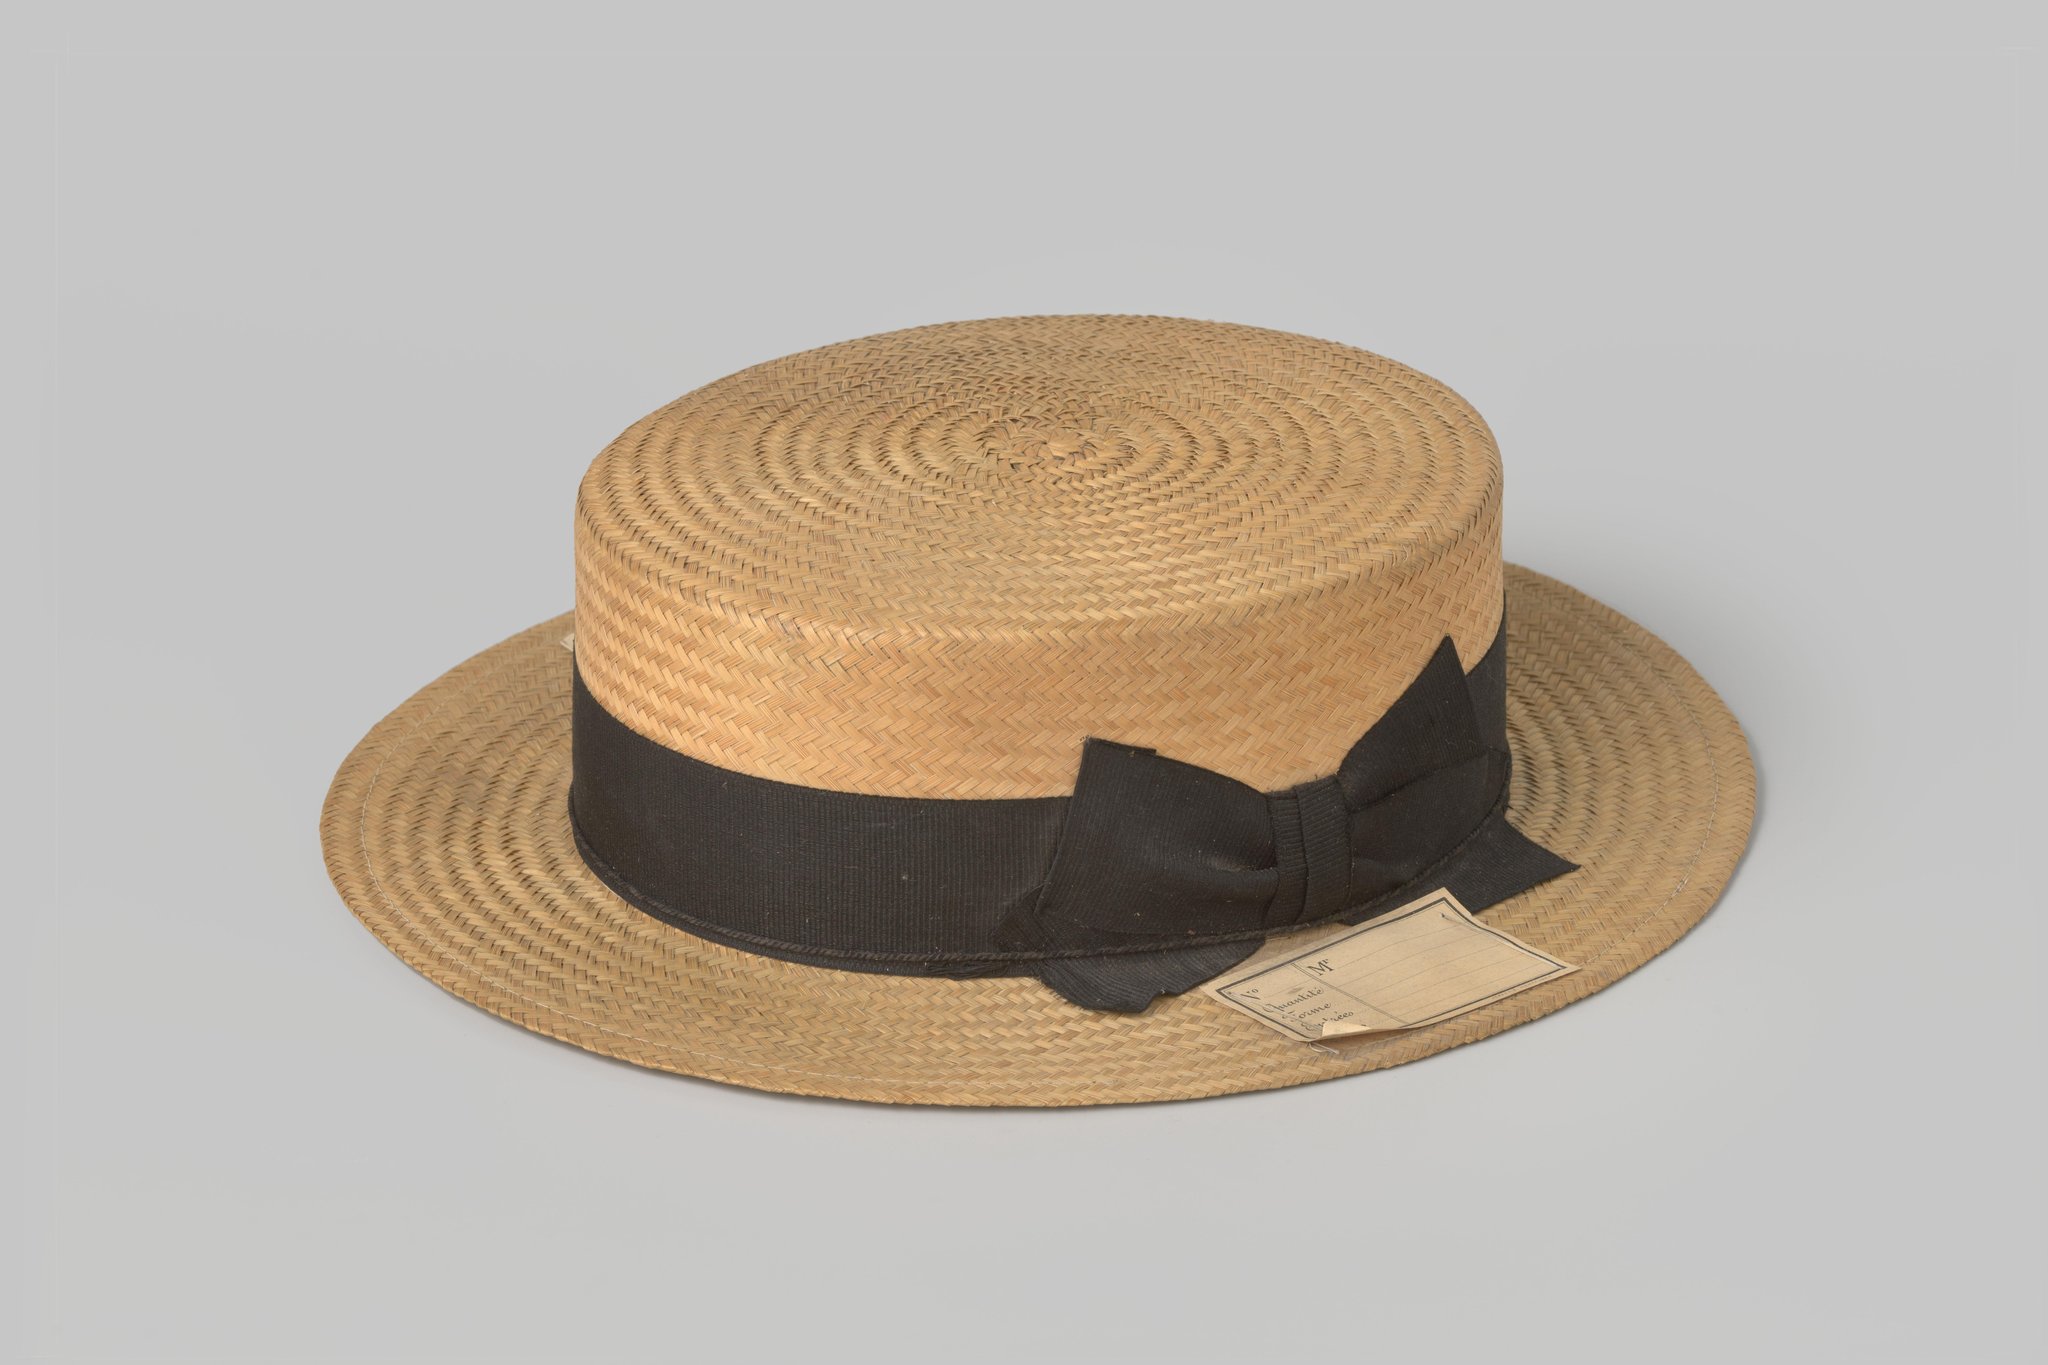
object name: clothing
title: Hoed van naturelkleurig gevlochten stro met platte bol, waar omheen zwart ripslint met platte strik, en brede rechte rand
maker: Anonymous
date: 1910-1930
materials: rib, ribbon, straw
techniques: braiding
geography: france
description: Hoed van naturelkleurig gevlochten stro met platte bol, waar omheen zwart ripslint met platte strik, en brede rechte rand. Ovaal, plat. Adres: I. Nr.II/F:Cyrano. R. et II. No.-/Quantité/Forme/Entrées/Bords/Mr...